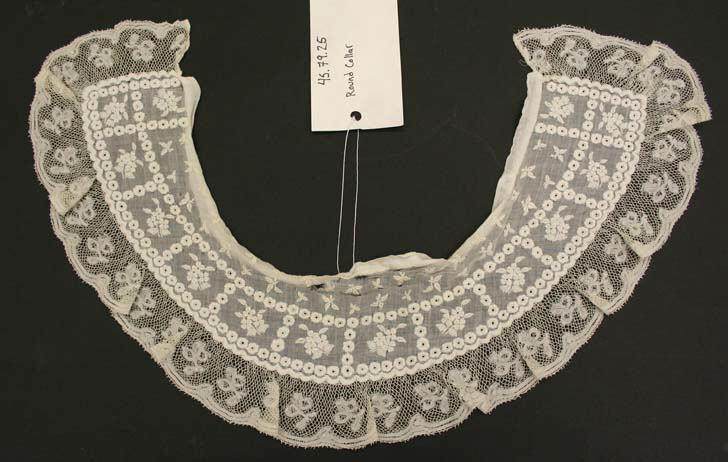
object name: collar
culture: american or european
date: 1700-1945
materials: cotton